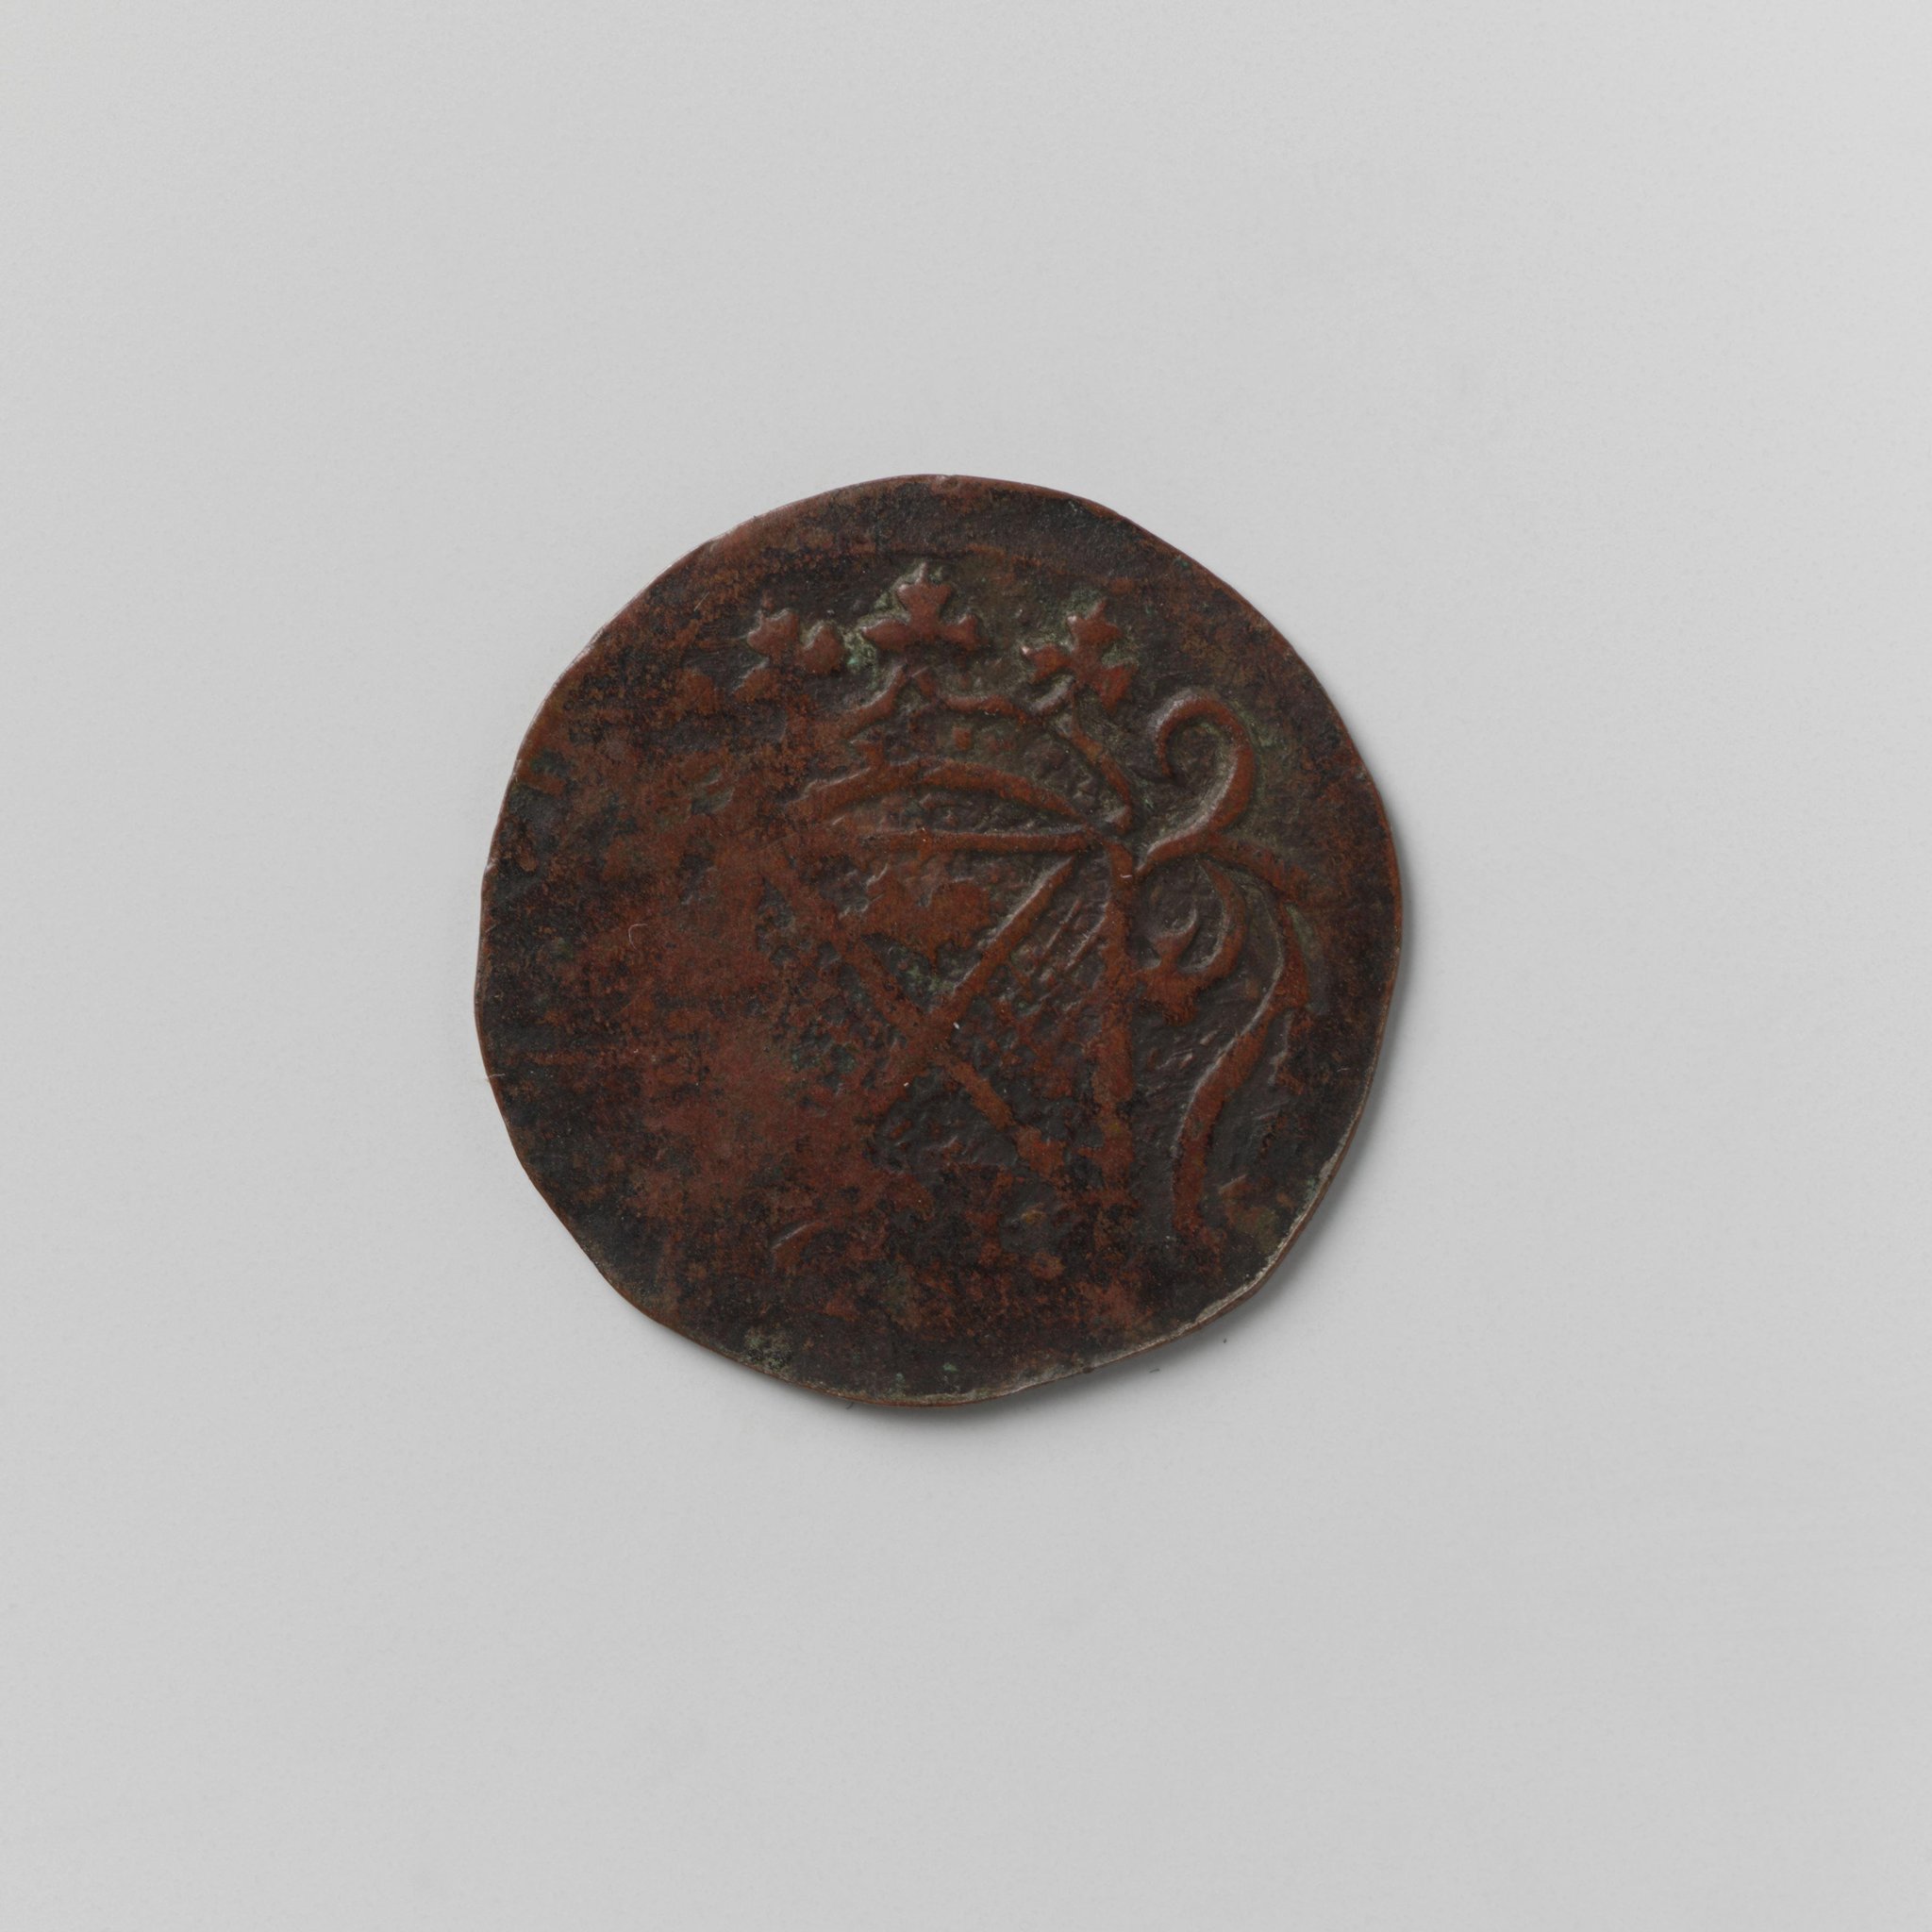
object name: coin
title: Nabootsing van VOC- duit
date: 1780-1830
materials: copper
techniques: striking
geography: banjarmasin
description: Koperen munt. Nabootsing van duit van de VOC. Voorzijde: gekroond fictief wapenschild. Keerzijde: monogram van de VOC, waarboven onduidelijke figuur en waaronder fictief jaartal.